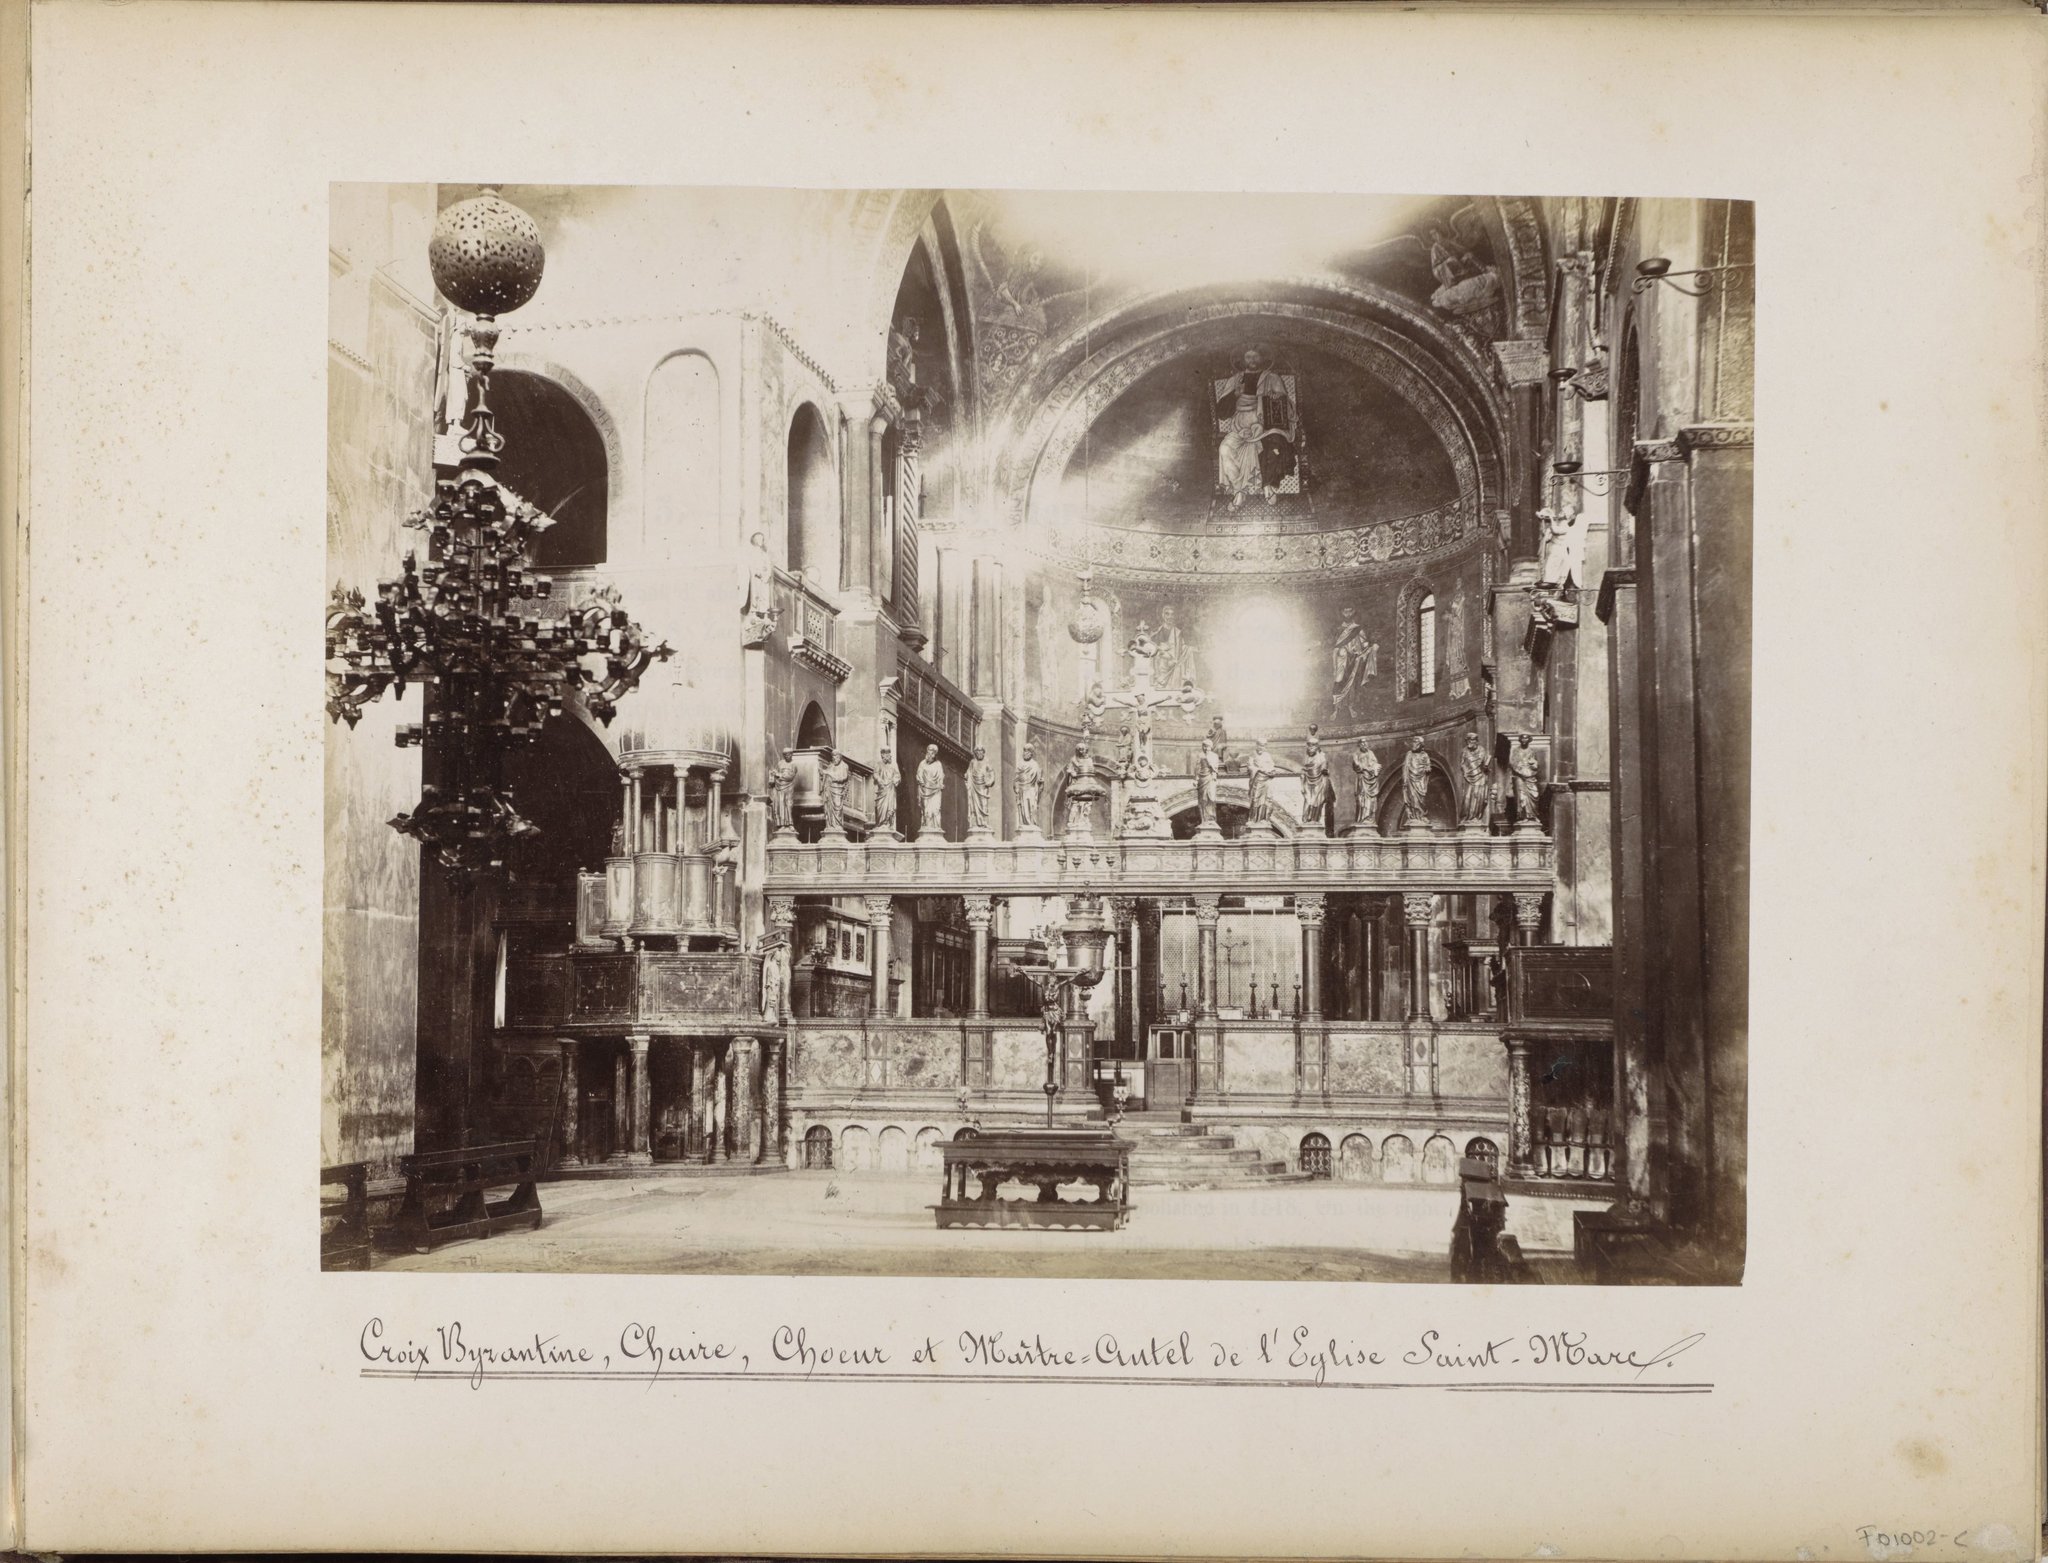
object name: photograph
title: Koor, Byzantijns kruis, hoofdaltaar en retabel van de basiliek van San Marco in Venetië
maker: carlo ponti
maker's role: fotograaf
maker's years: 1820-1893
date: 1860-1881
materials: photographic support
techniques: albumen print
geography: venice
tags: parts of church interior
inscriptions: check stamp: ‘Carlo Ponti Venezia’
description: Onderdeel van Topografisch album van Venetië 1881.